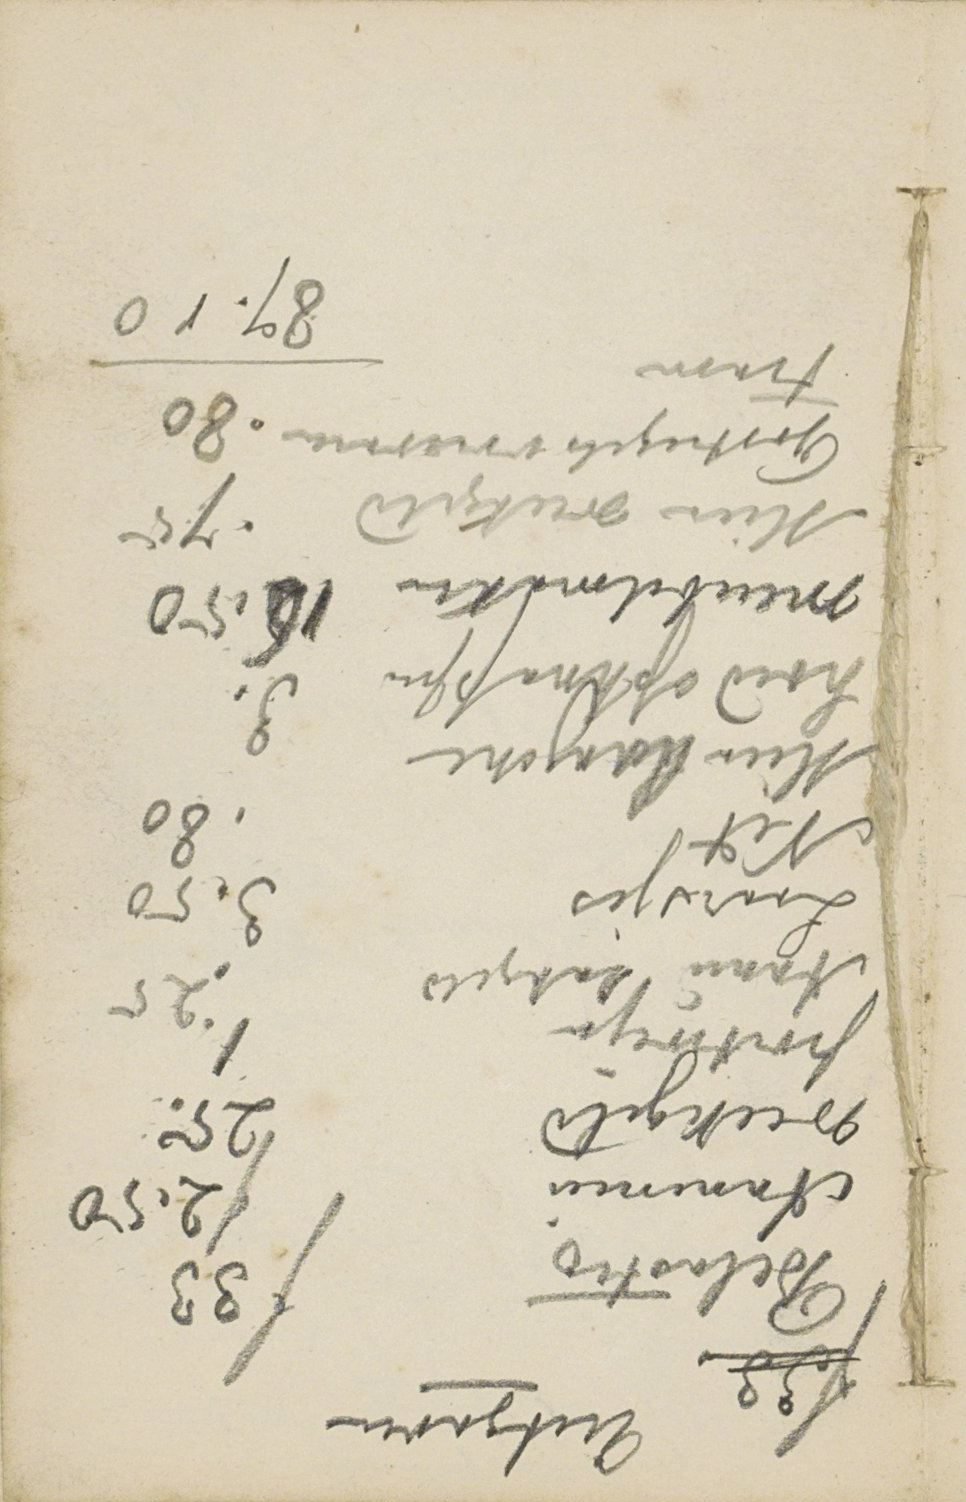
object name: sketchbook leaf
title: Lijst met uitgaven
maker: willem koekkoek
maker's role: draughtsman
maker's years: 1839-1895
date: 1849-1895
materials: paper, pencil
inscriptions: annotation: ‘Uitgaven/ f333/ Belasting f33/ Annemie f2.50/ weekgeld 25./ portwijn 1/ Annie zakgeld .25/ [...]’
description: Blad 55 verso uit een schetsboek met 57 bladen.